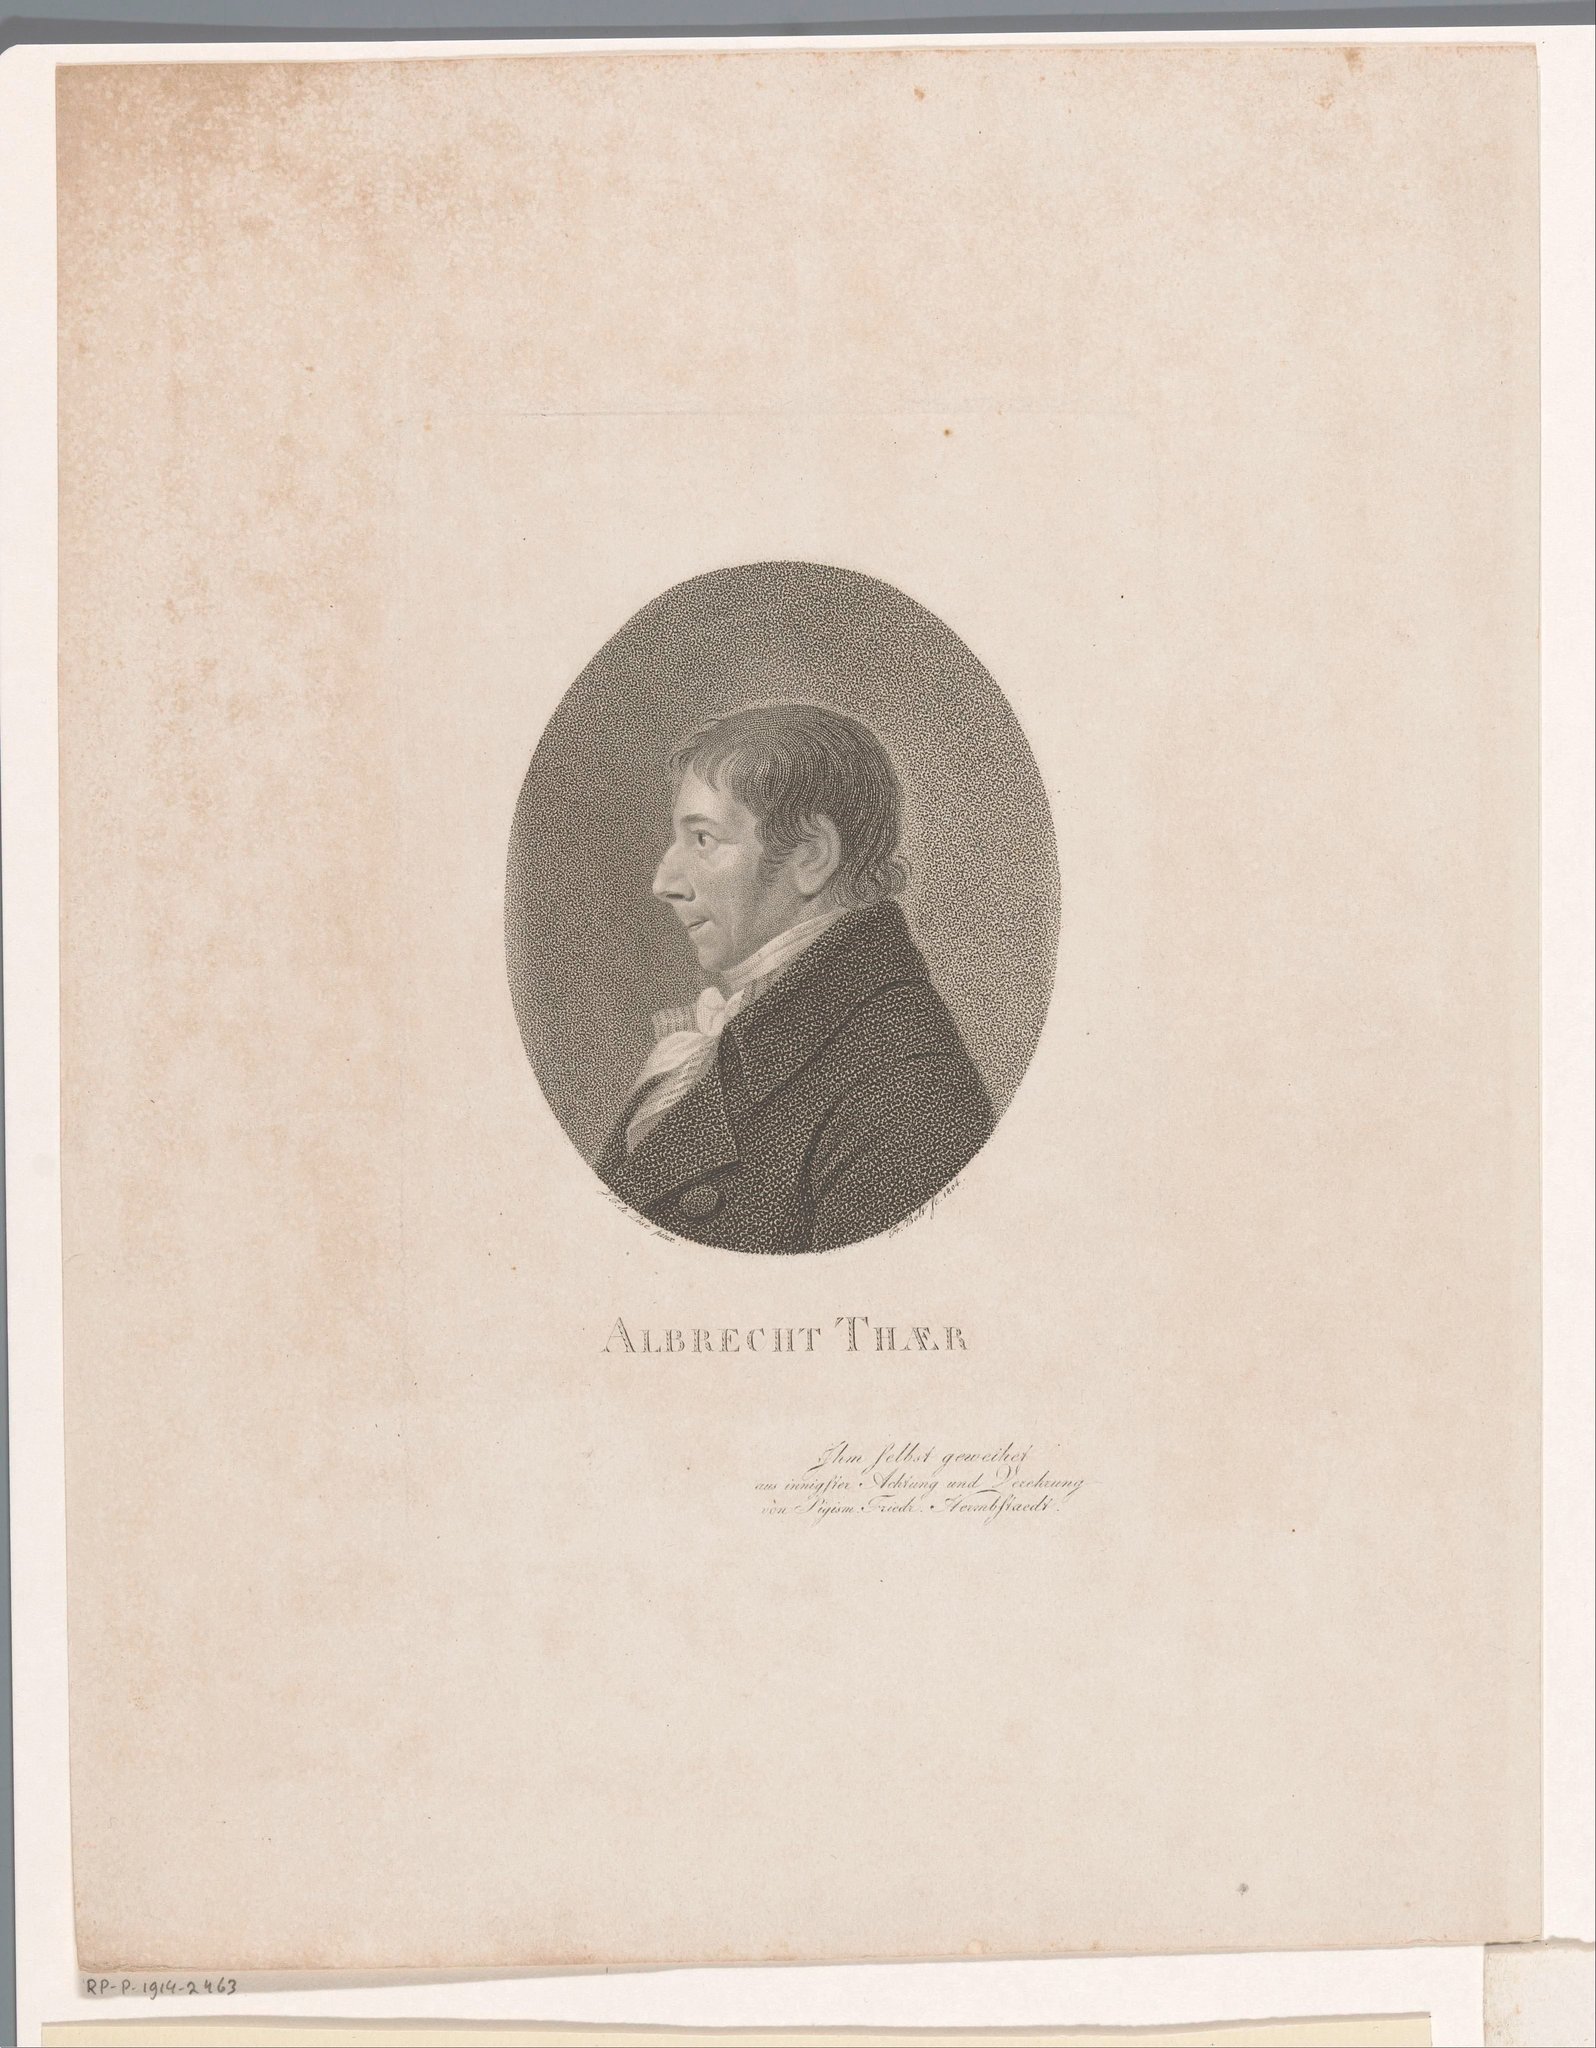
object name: print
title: Portret van Albrecht Daniel Thaer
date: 1804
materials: paper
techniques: stippling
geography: berlin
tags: albrecht daniel thaer, historical persons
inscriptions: collector's mark: Lugt 2228